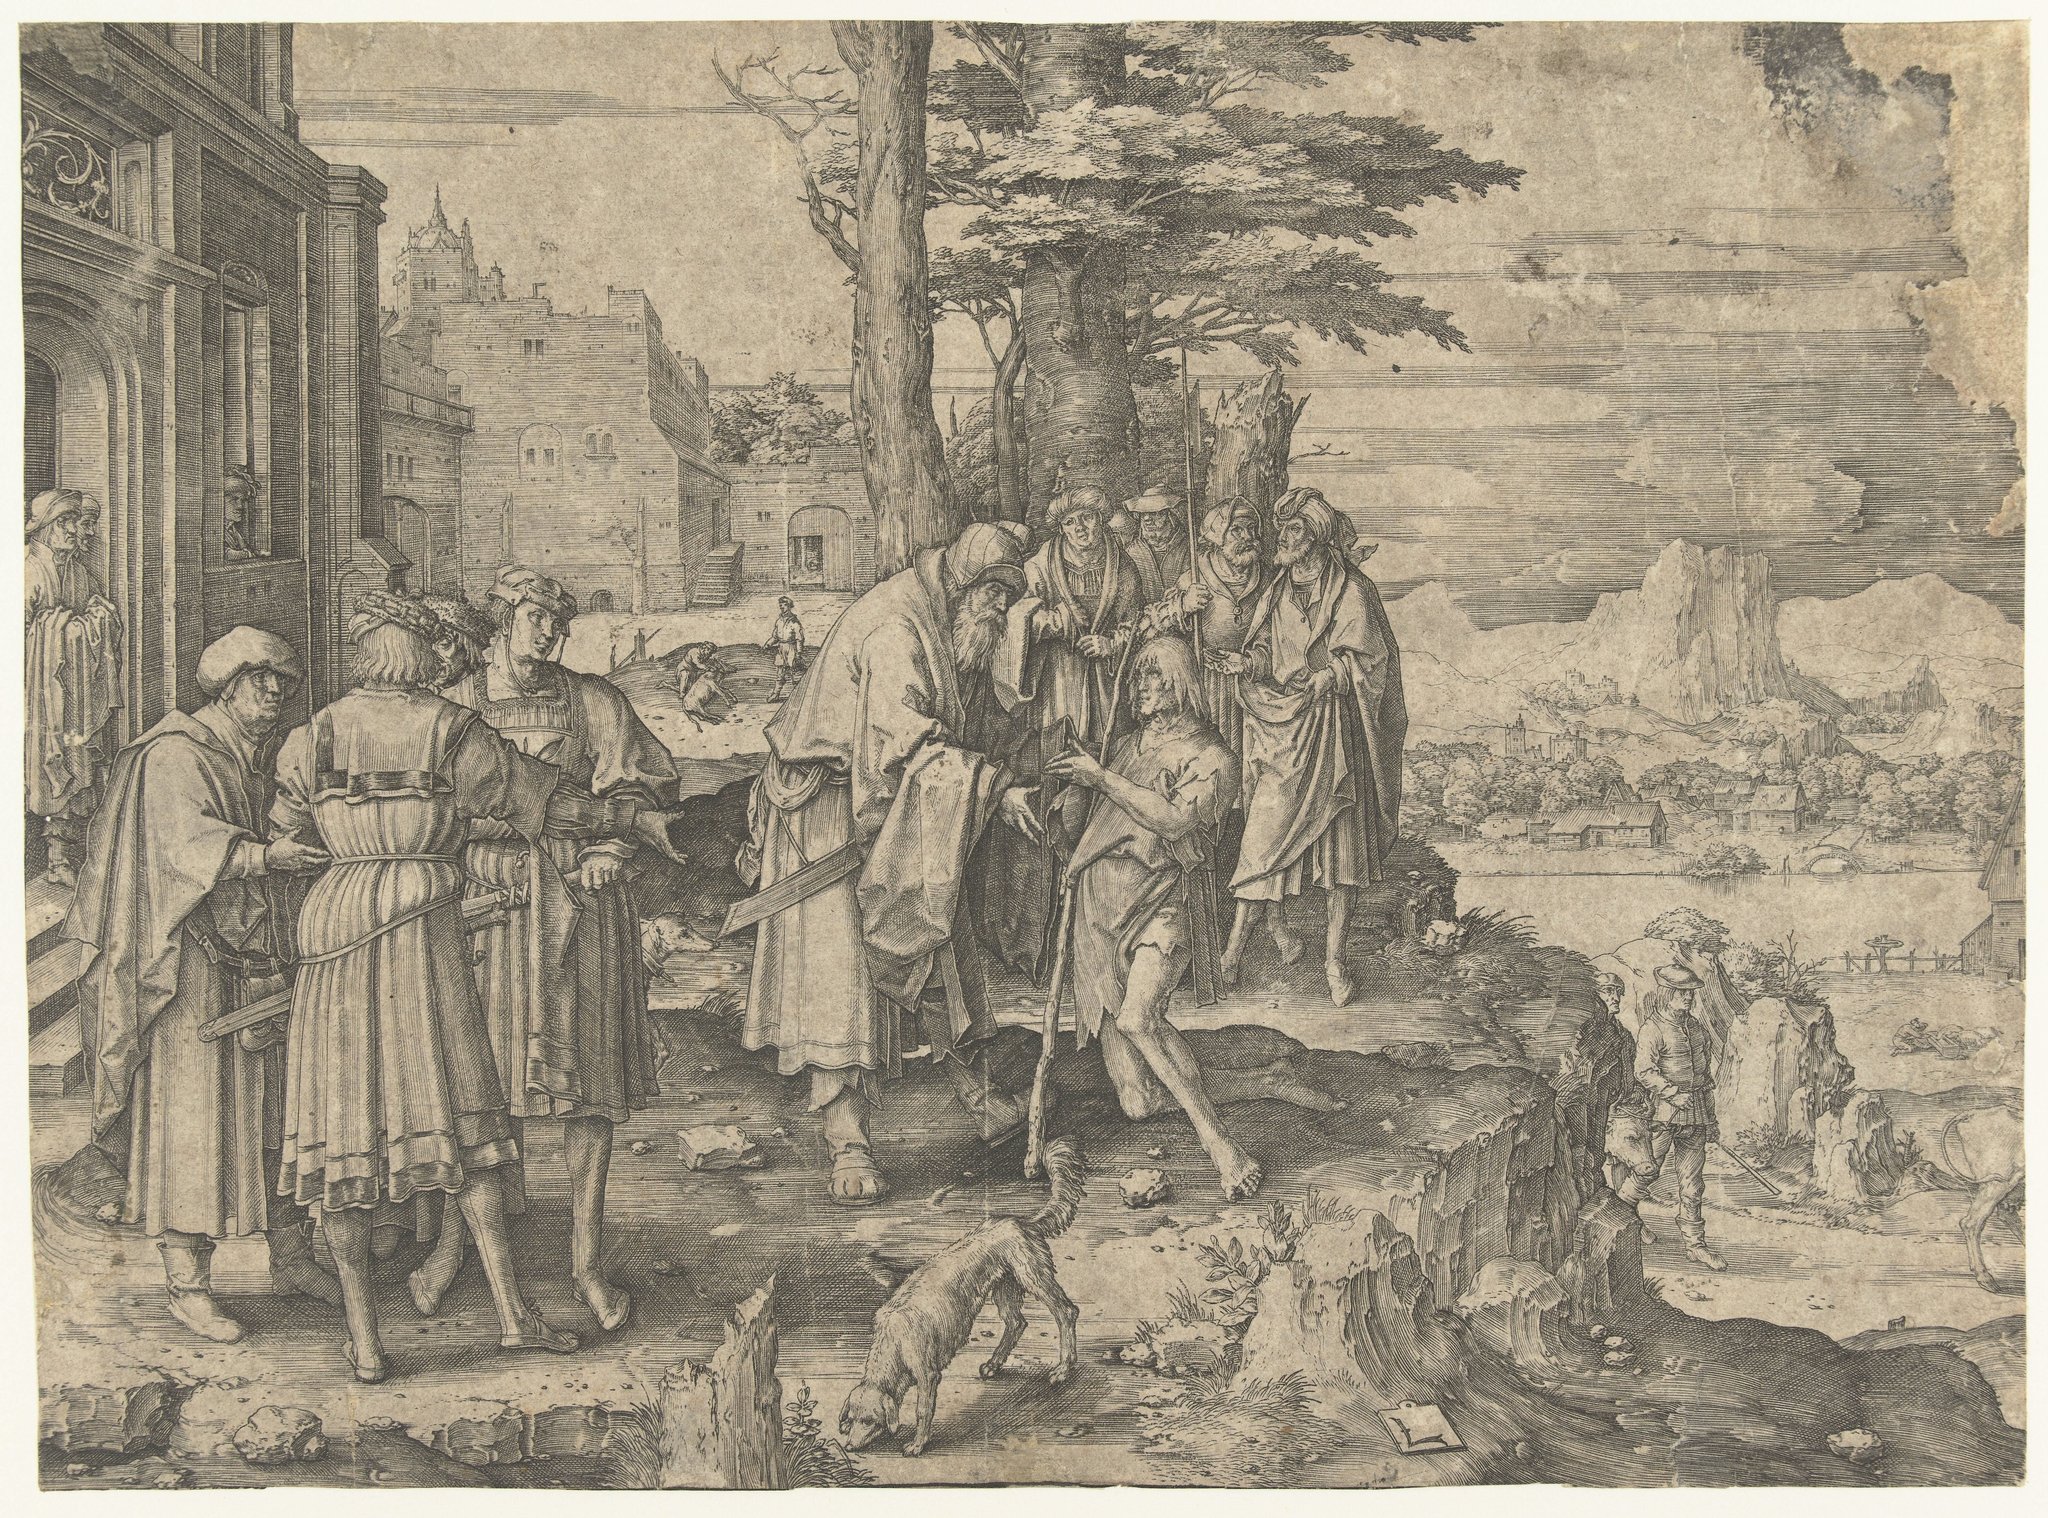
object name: print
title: De terugkeer van de verloren zoon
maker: lucas van leyden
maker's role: draughtsman, painter, print maker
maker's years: 1494-1533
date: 1508-1512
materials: paper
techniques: engraving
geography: low countries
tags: the prodigal son returns home, where his father awaits him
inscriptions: collector's mark: Lugt 11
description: Voor het ouderlijk huis wordt de schamel geklede verloren zoon verwelkomd door zijn vader in bijzijn van vele omstanders. Heuvelachtig landschap met rivier en slachting van het kalf op de achtergrond.